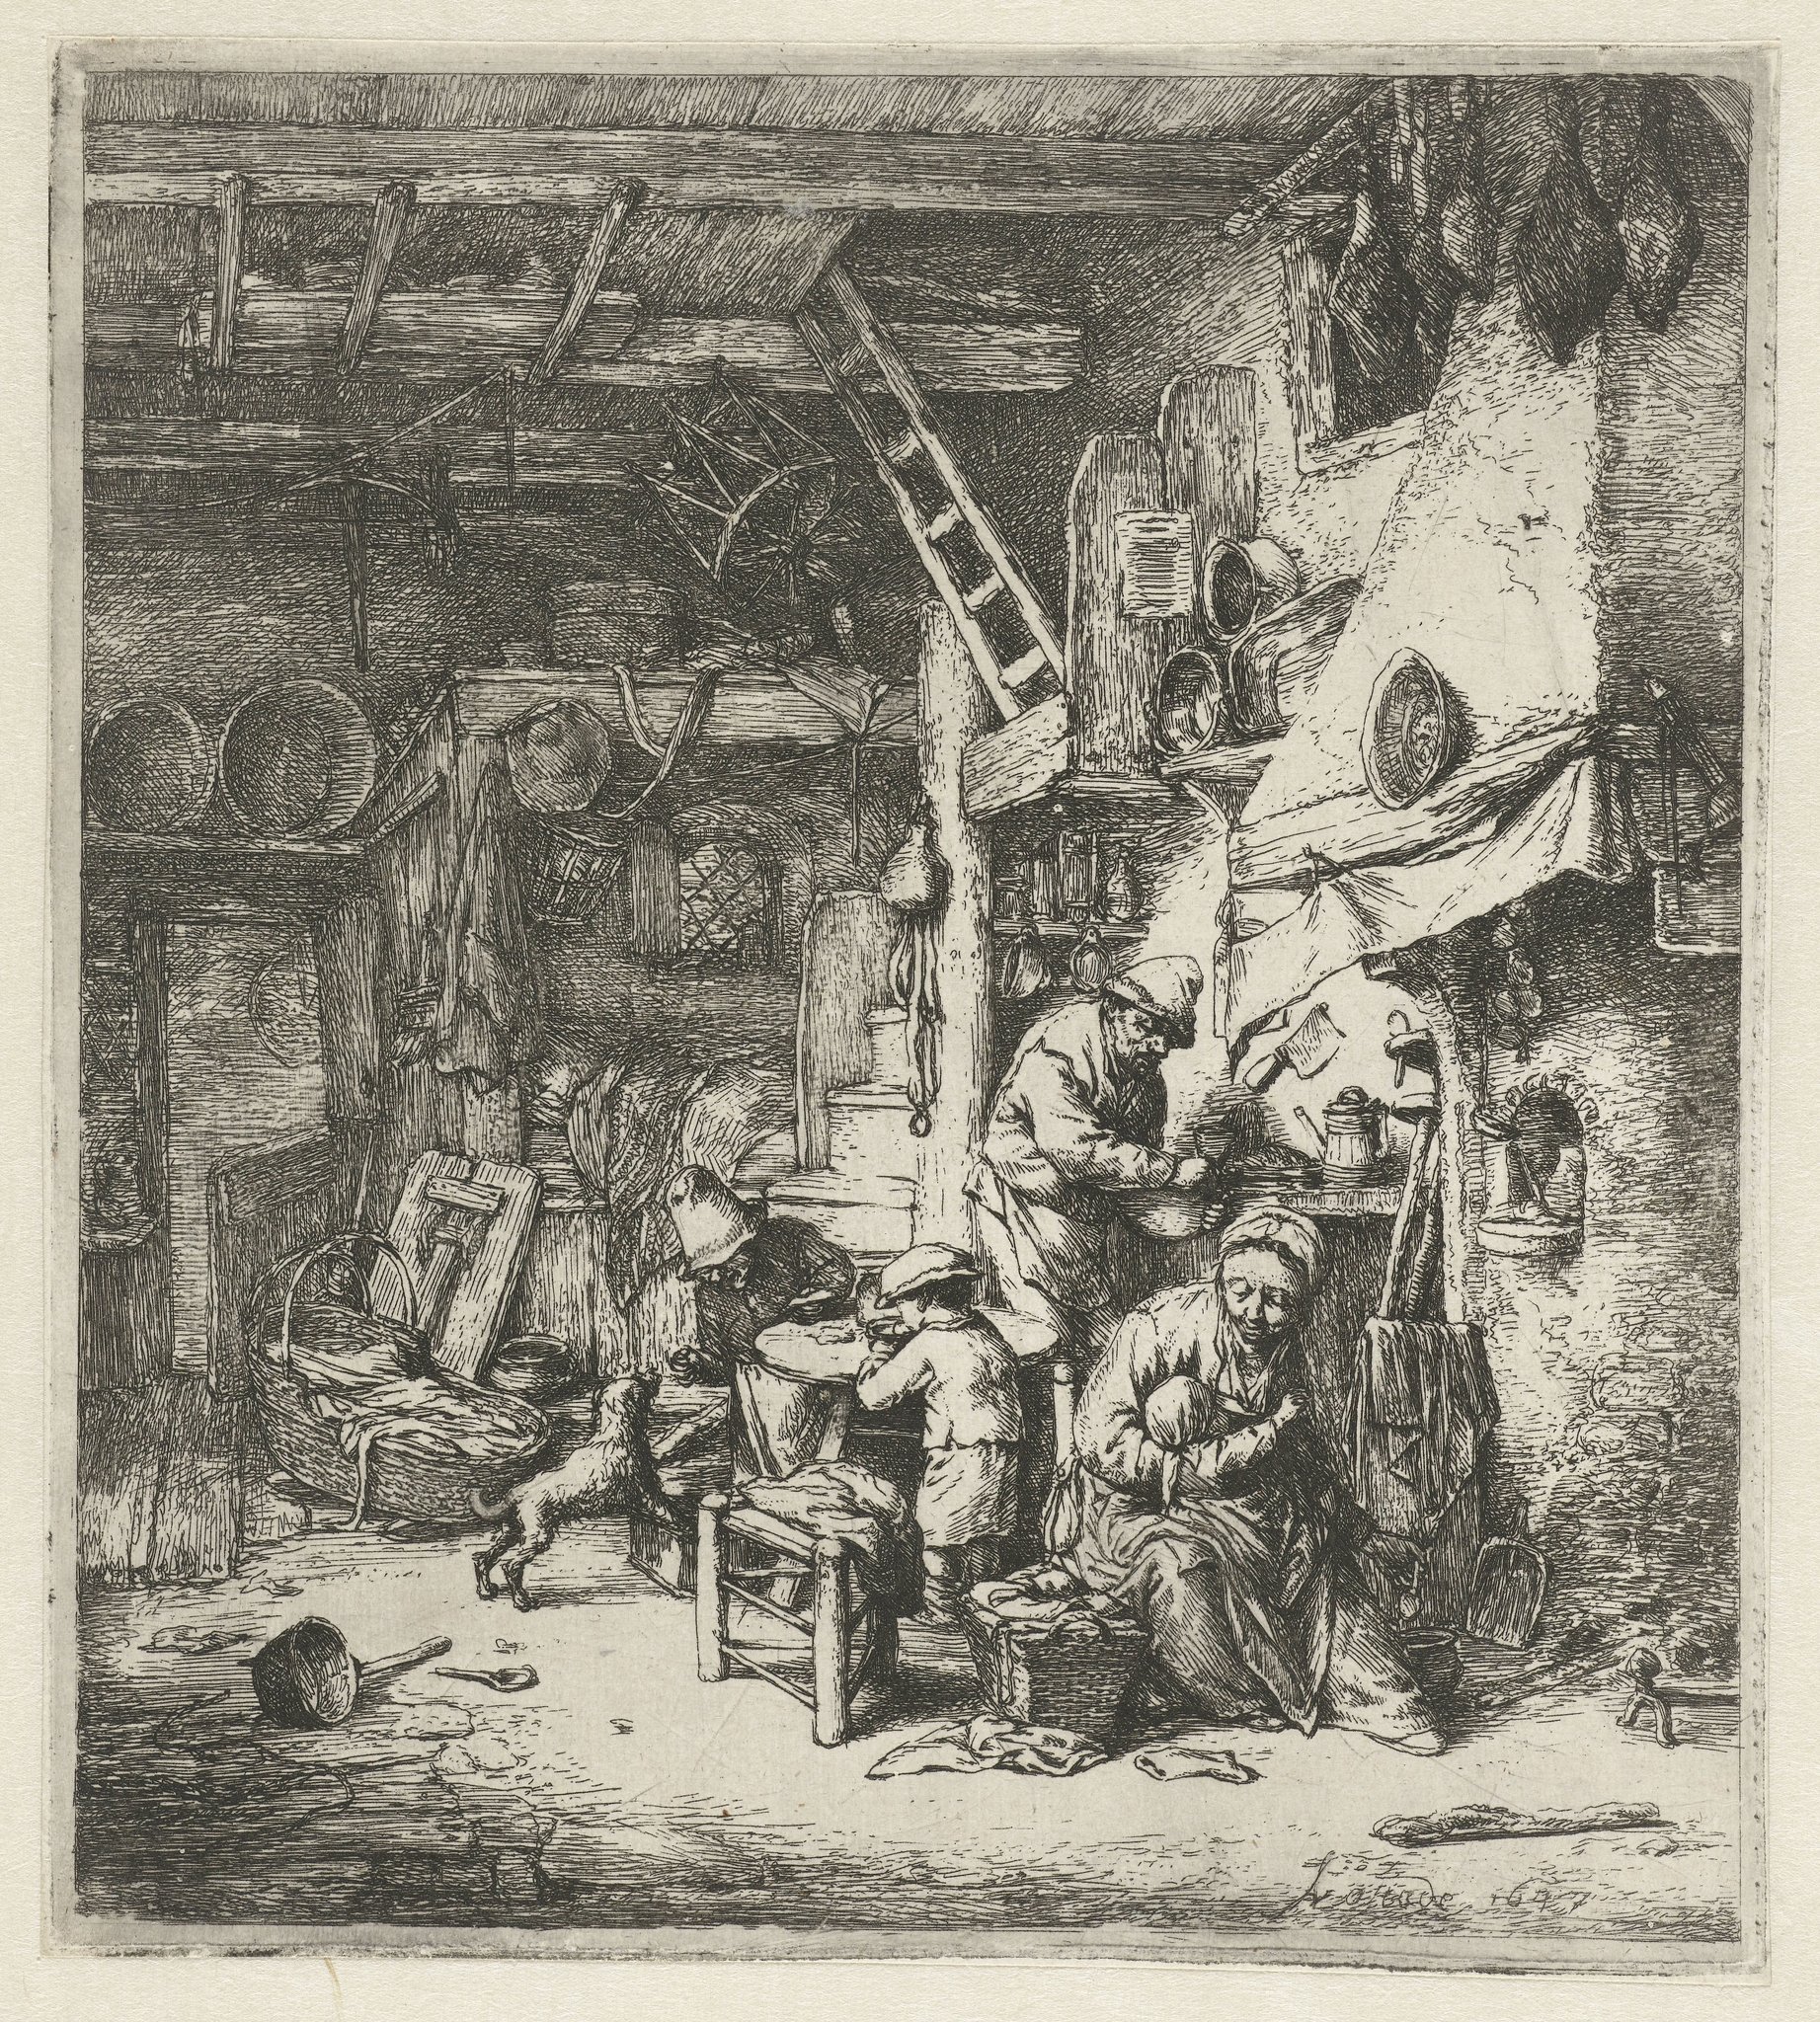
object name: print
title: Het boerenhuishouden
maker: adriaen van ostade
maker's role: draughtsman, painter, print maker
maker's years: 1610-1685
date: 1647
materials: paper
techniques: etching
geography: haarlem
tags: interior of the house, family life at home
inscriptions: collector's mark: Lugt 240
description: Eenvoudig woonvertrek met boerengezin tijdens dagelijkse bezigheden. De boerin ontfermt zich over haar jongste kind terwijl een jongen aan tafel eet uit een kom en de boer een snee brood snijdt. Een andere jongen speelt met een hond. De ruimte staat vol met huishoudelijke voorwerpen en meubels.